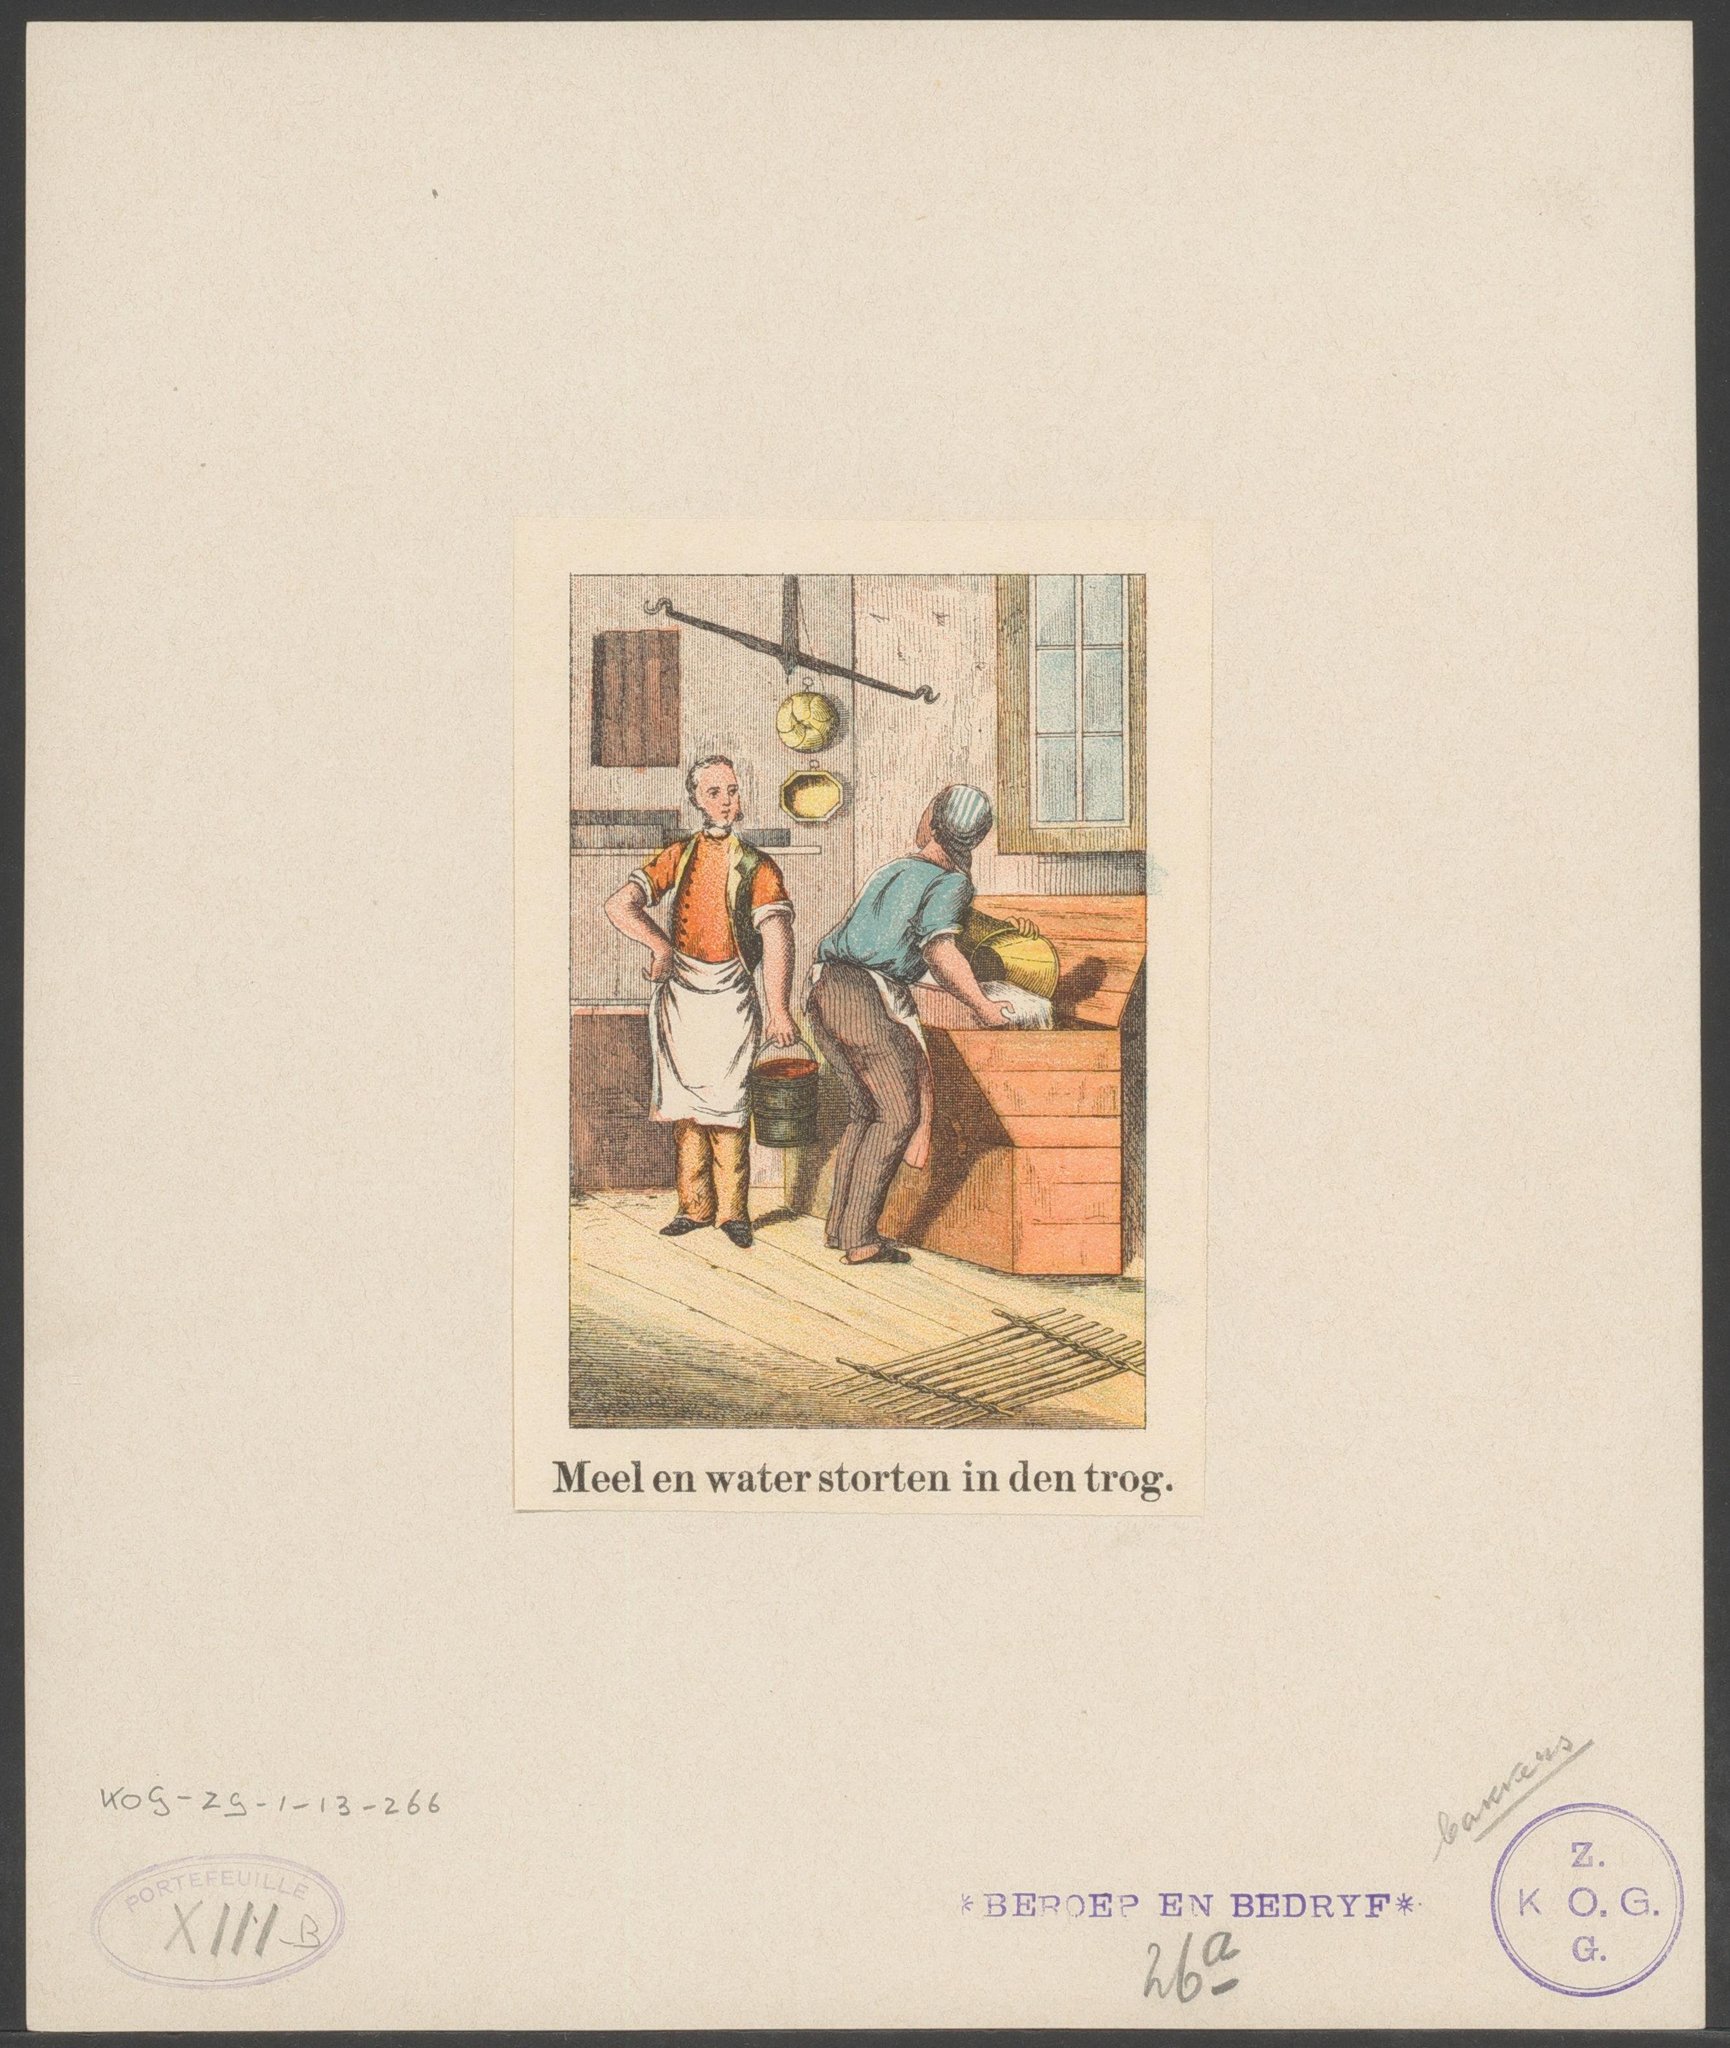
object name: print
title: Meel en water storten in den trog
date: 1865-1872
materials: paper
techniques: lithograph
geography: amsterdam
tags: baker (+ labourers ~ crafts, industries, agriculture), baker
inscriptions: stamp, collector's mark: Lugt 1641, stamp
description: Onderwerpsrubrieken binnen de Atlas Zeden en Gewoonten: Handel, Nijverheid en Verkeer, Beroep en bedrijf, Mannelijk, Eet- en drinkwaren.